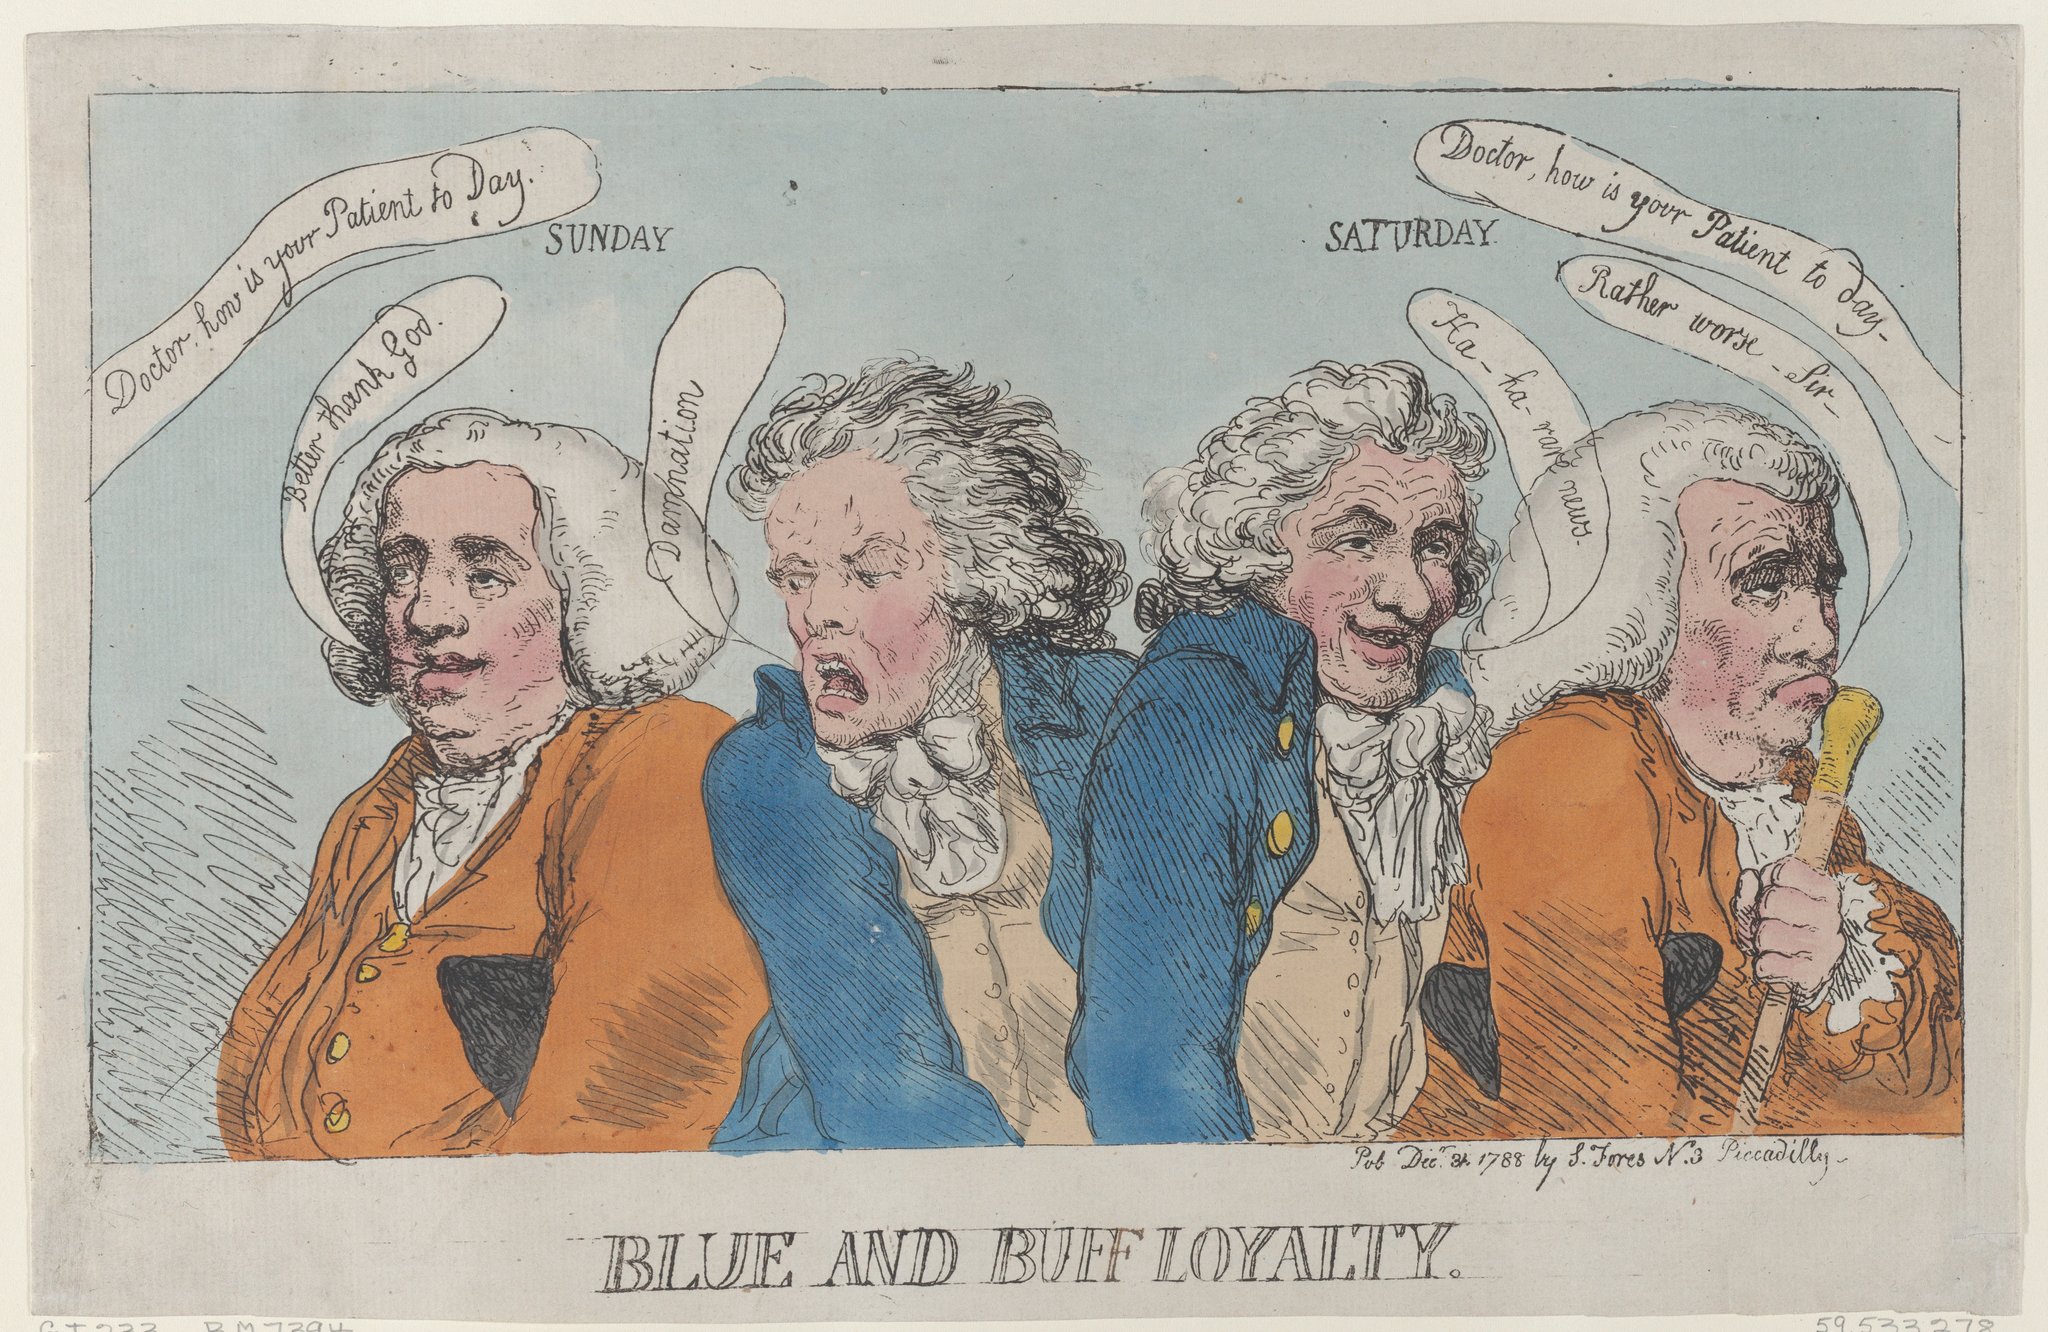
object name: print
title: Blue and Buff Loyalty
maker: thomas rowlandson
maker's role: artist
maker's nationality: british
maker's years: 1757-1827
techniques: etching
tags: satire,men